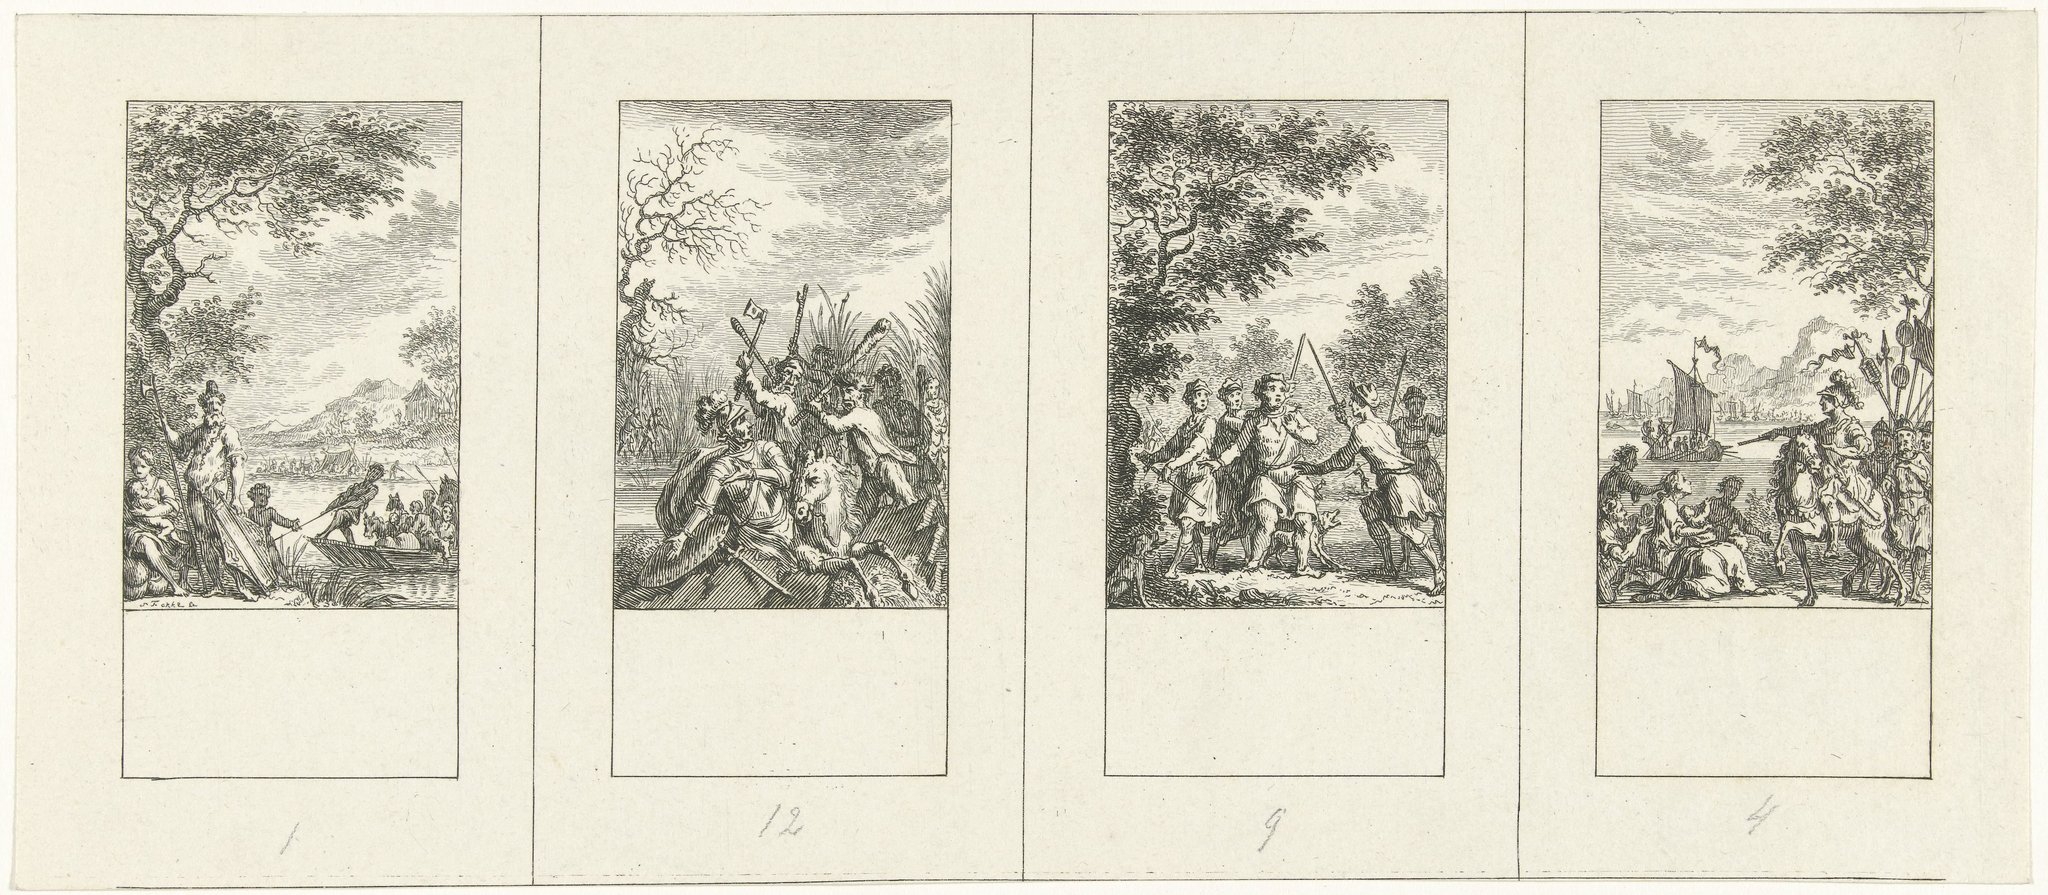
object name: print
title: Illustraties vaderlandse geschiedenis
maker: simon fokke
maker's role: draughtsman, print maker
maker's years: 1712-1784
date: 1722-1784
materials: paper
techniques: etching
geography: amsterdam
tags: earl, historical events and situations, historical persons (portraits and scenes from the life)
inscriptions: collector's mark: Lugt 240, number: ‘1, 12, 9, 4’